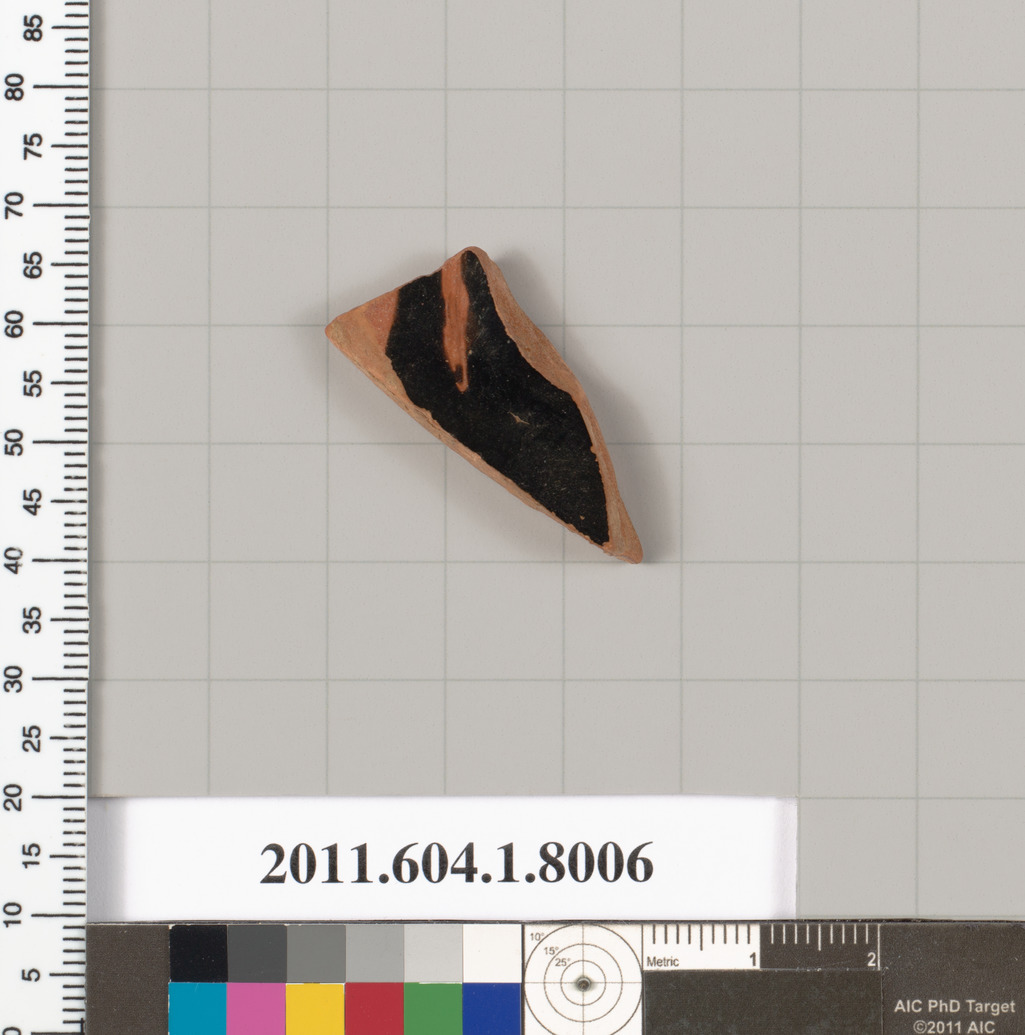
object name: kylix fragment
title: Terracotta rim fragment of a kylix (drinking cup)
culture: greek, attic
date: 460-450 BCE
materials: terracotta